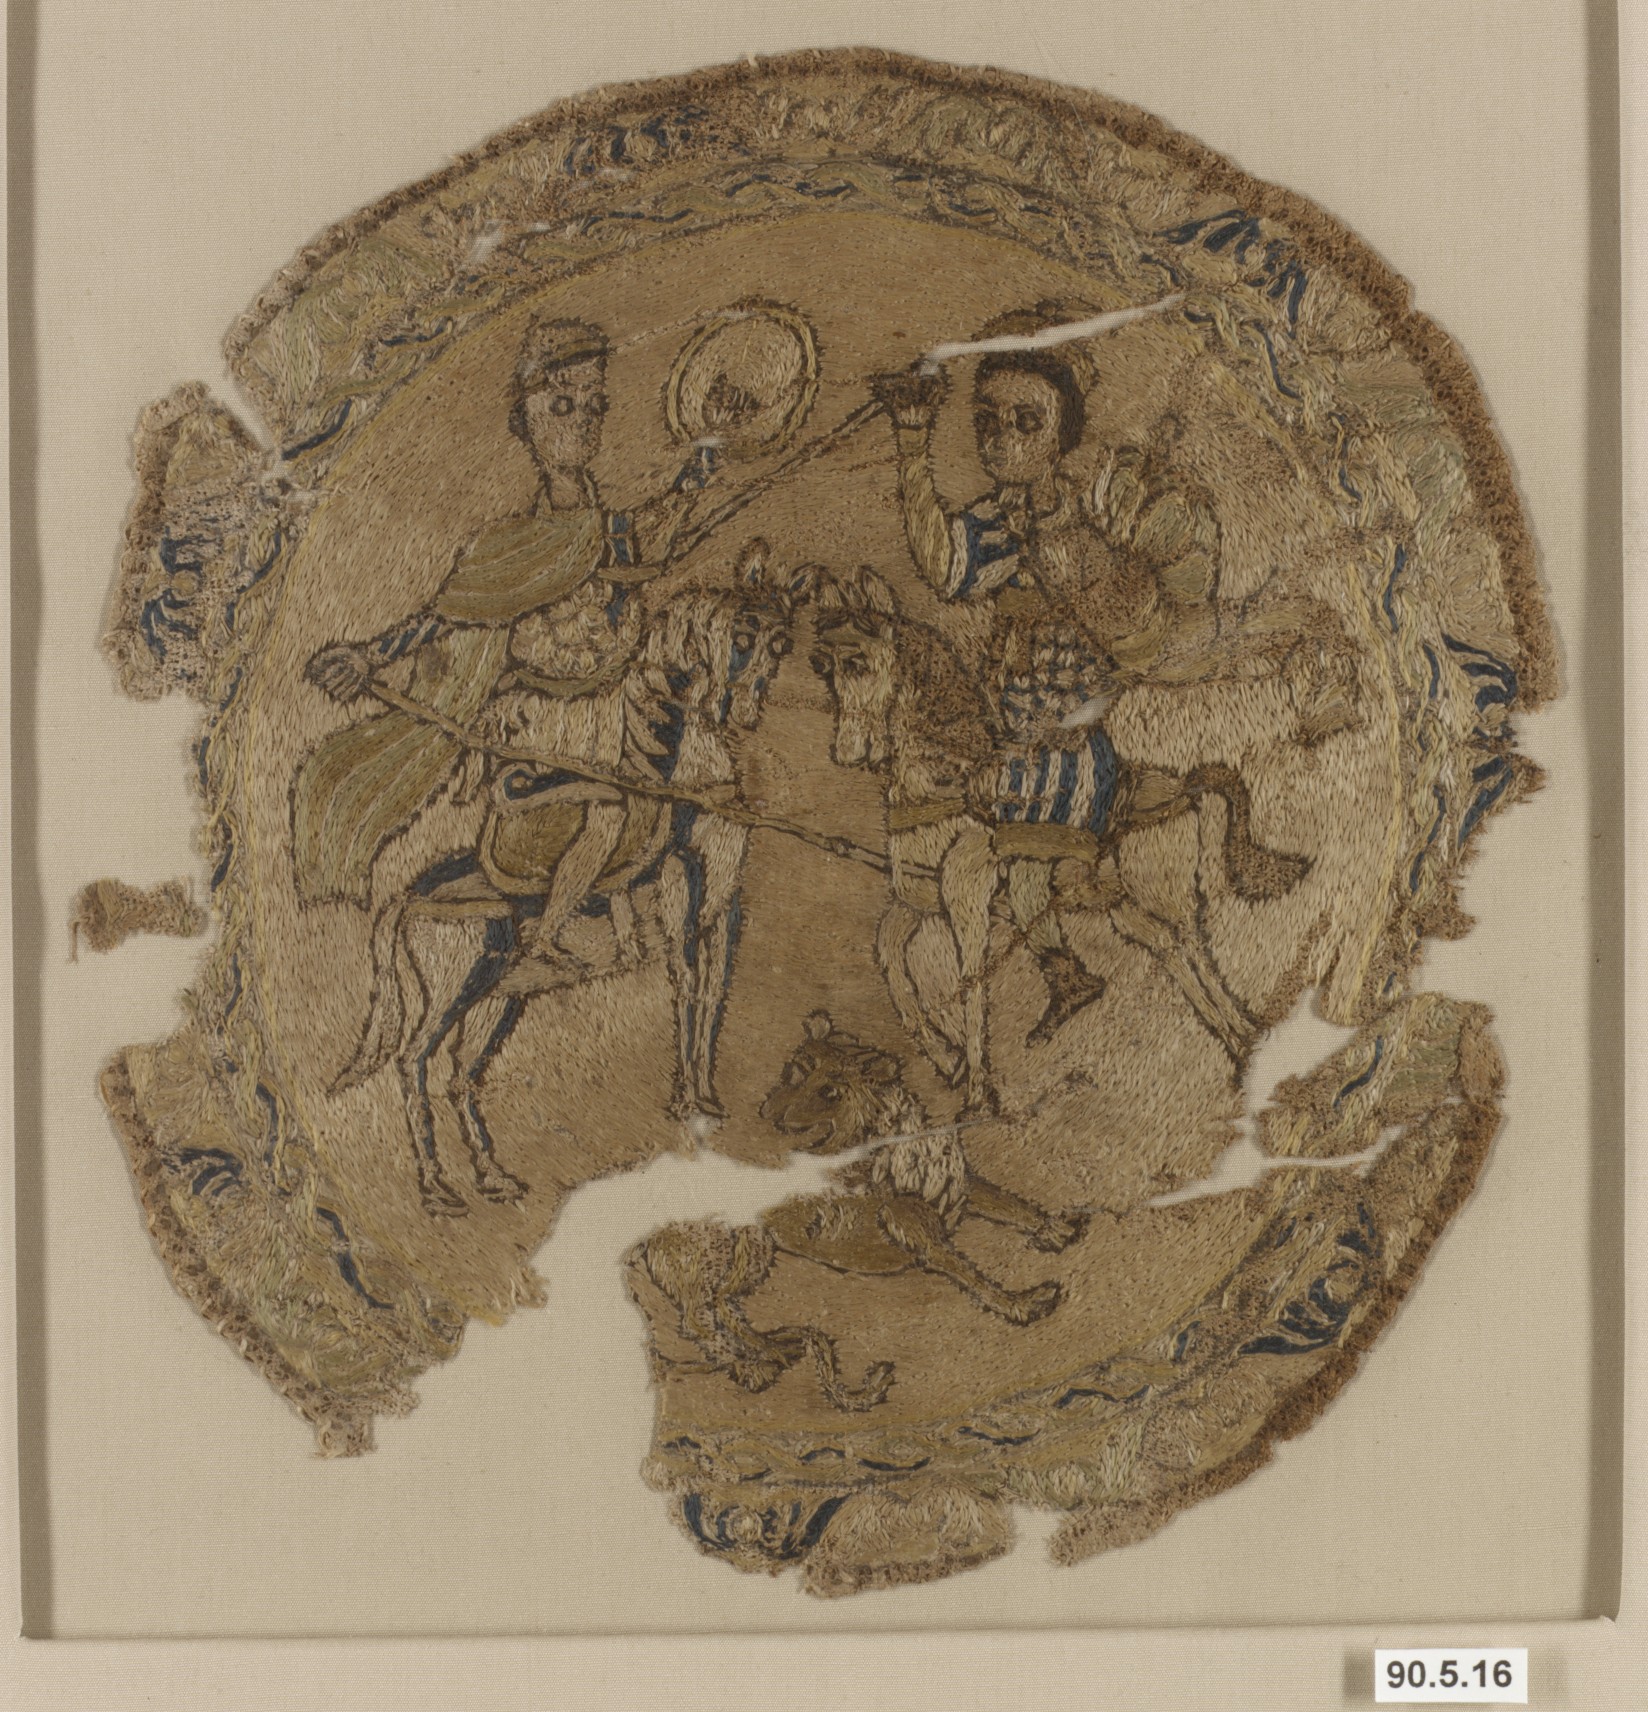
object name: roundel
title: Roundel with Mounted Warriors and a Lion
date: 501-700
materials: linen, silk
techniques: embroidery, weave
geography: egypt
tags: men,horses,lions